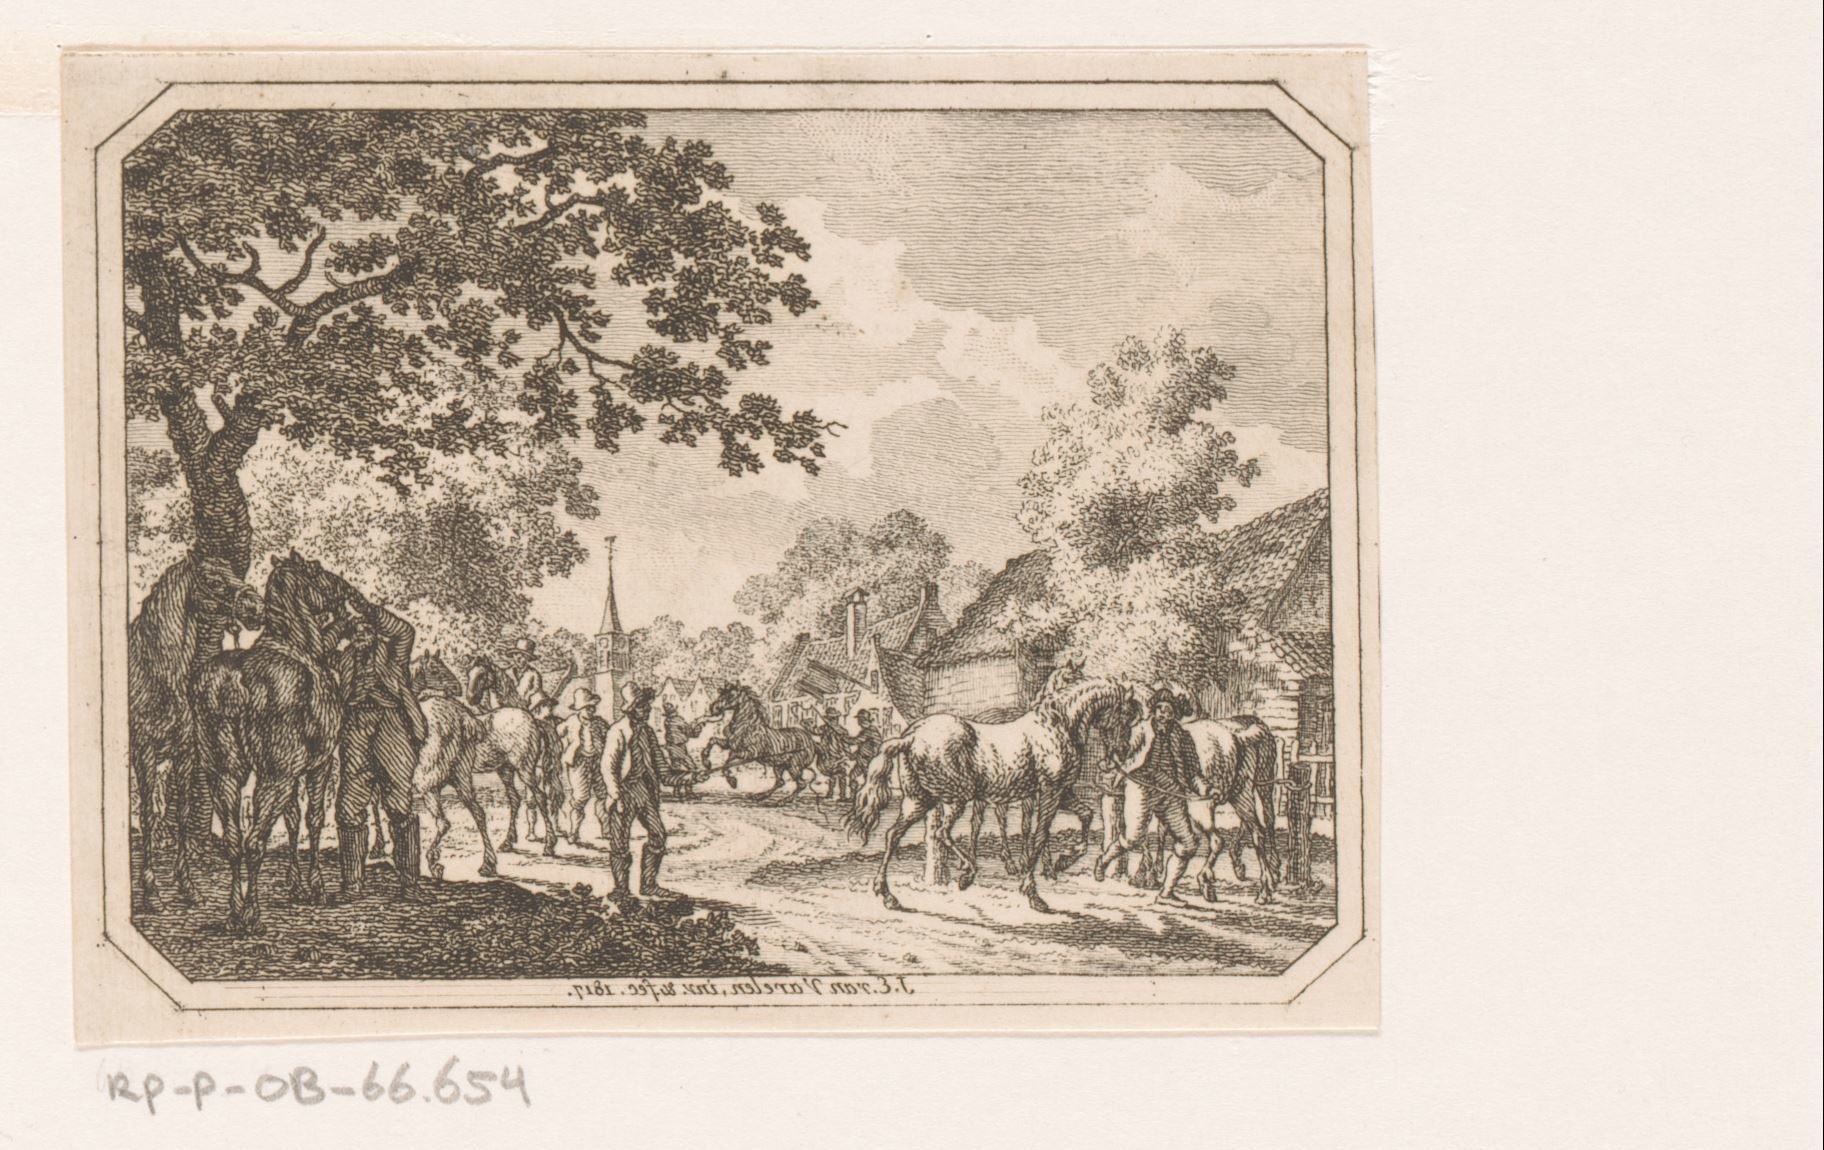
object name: print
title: Ontmoeting van Jakob en Jozef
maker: caspar luyken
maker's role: draughtsman, print maker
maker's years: 1672-1708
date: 1698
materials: paper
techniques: etching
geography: amsterdam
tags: the meeting of jacob and joseph in goshen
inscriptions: collector's mark: Lugt 2228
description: Proefdruk van illustratie uit: Josephus, Flavius. XX. boeken van de oude geschiedenissen der joden, 4 delen. Amsterdam: Barent Visscher, Willem de Coup, Willem van Lamsveld, Andries van Damme, 1698, dl. I.